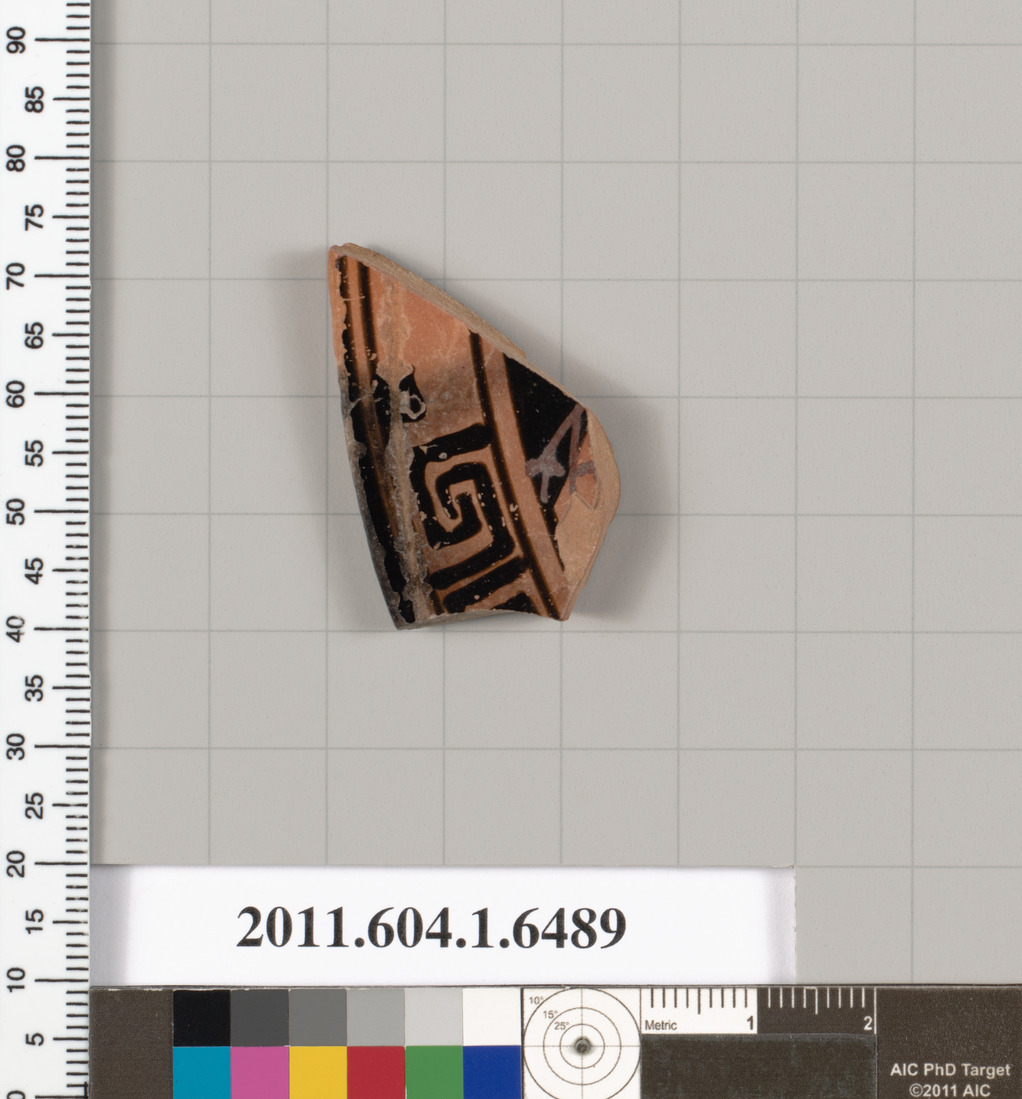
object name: kylix fragment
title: Terracotta fragment of a kylix (drinking cup)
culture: greek, attic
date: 490-480 BCE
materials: terracotta